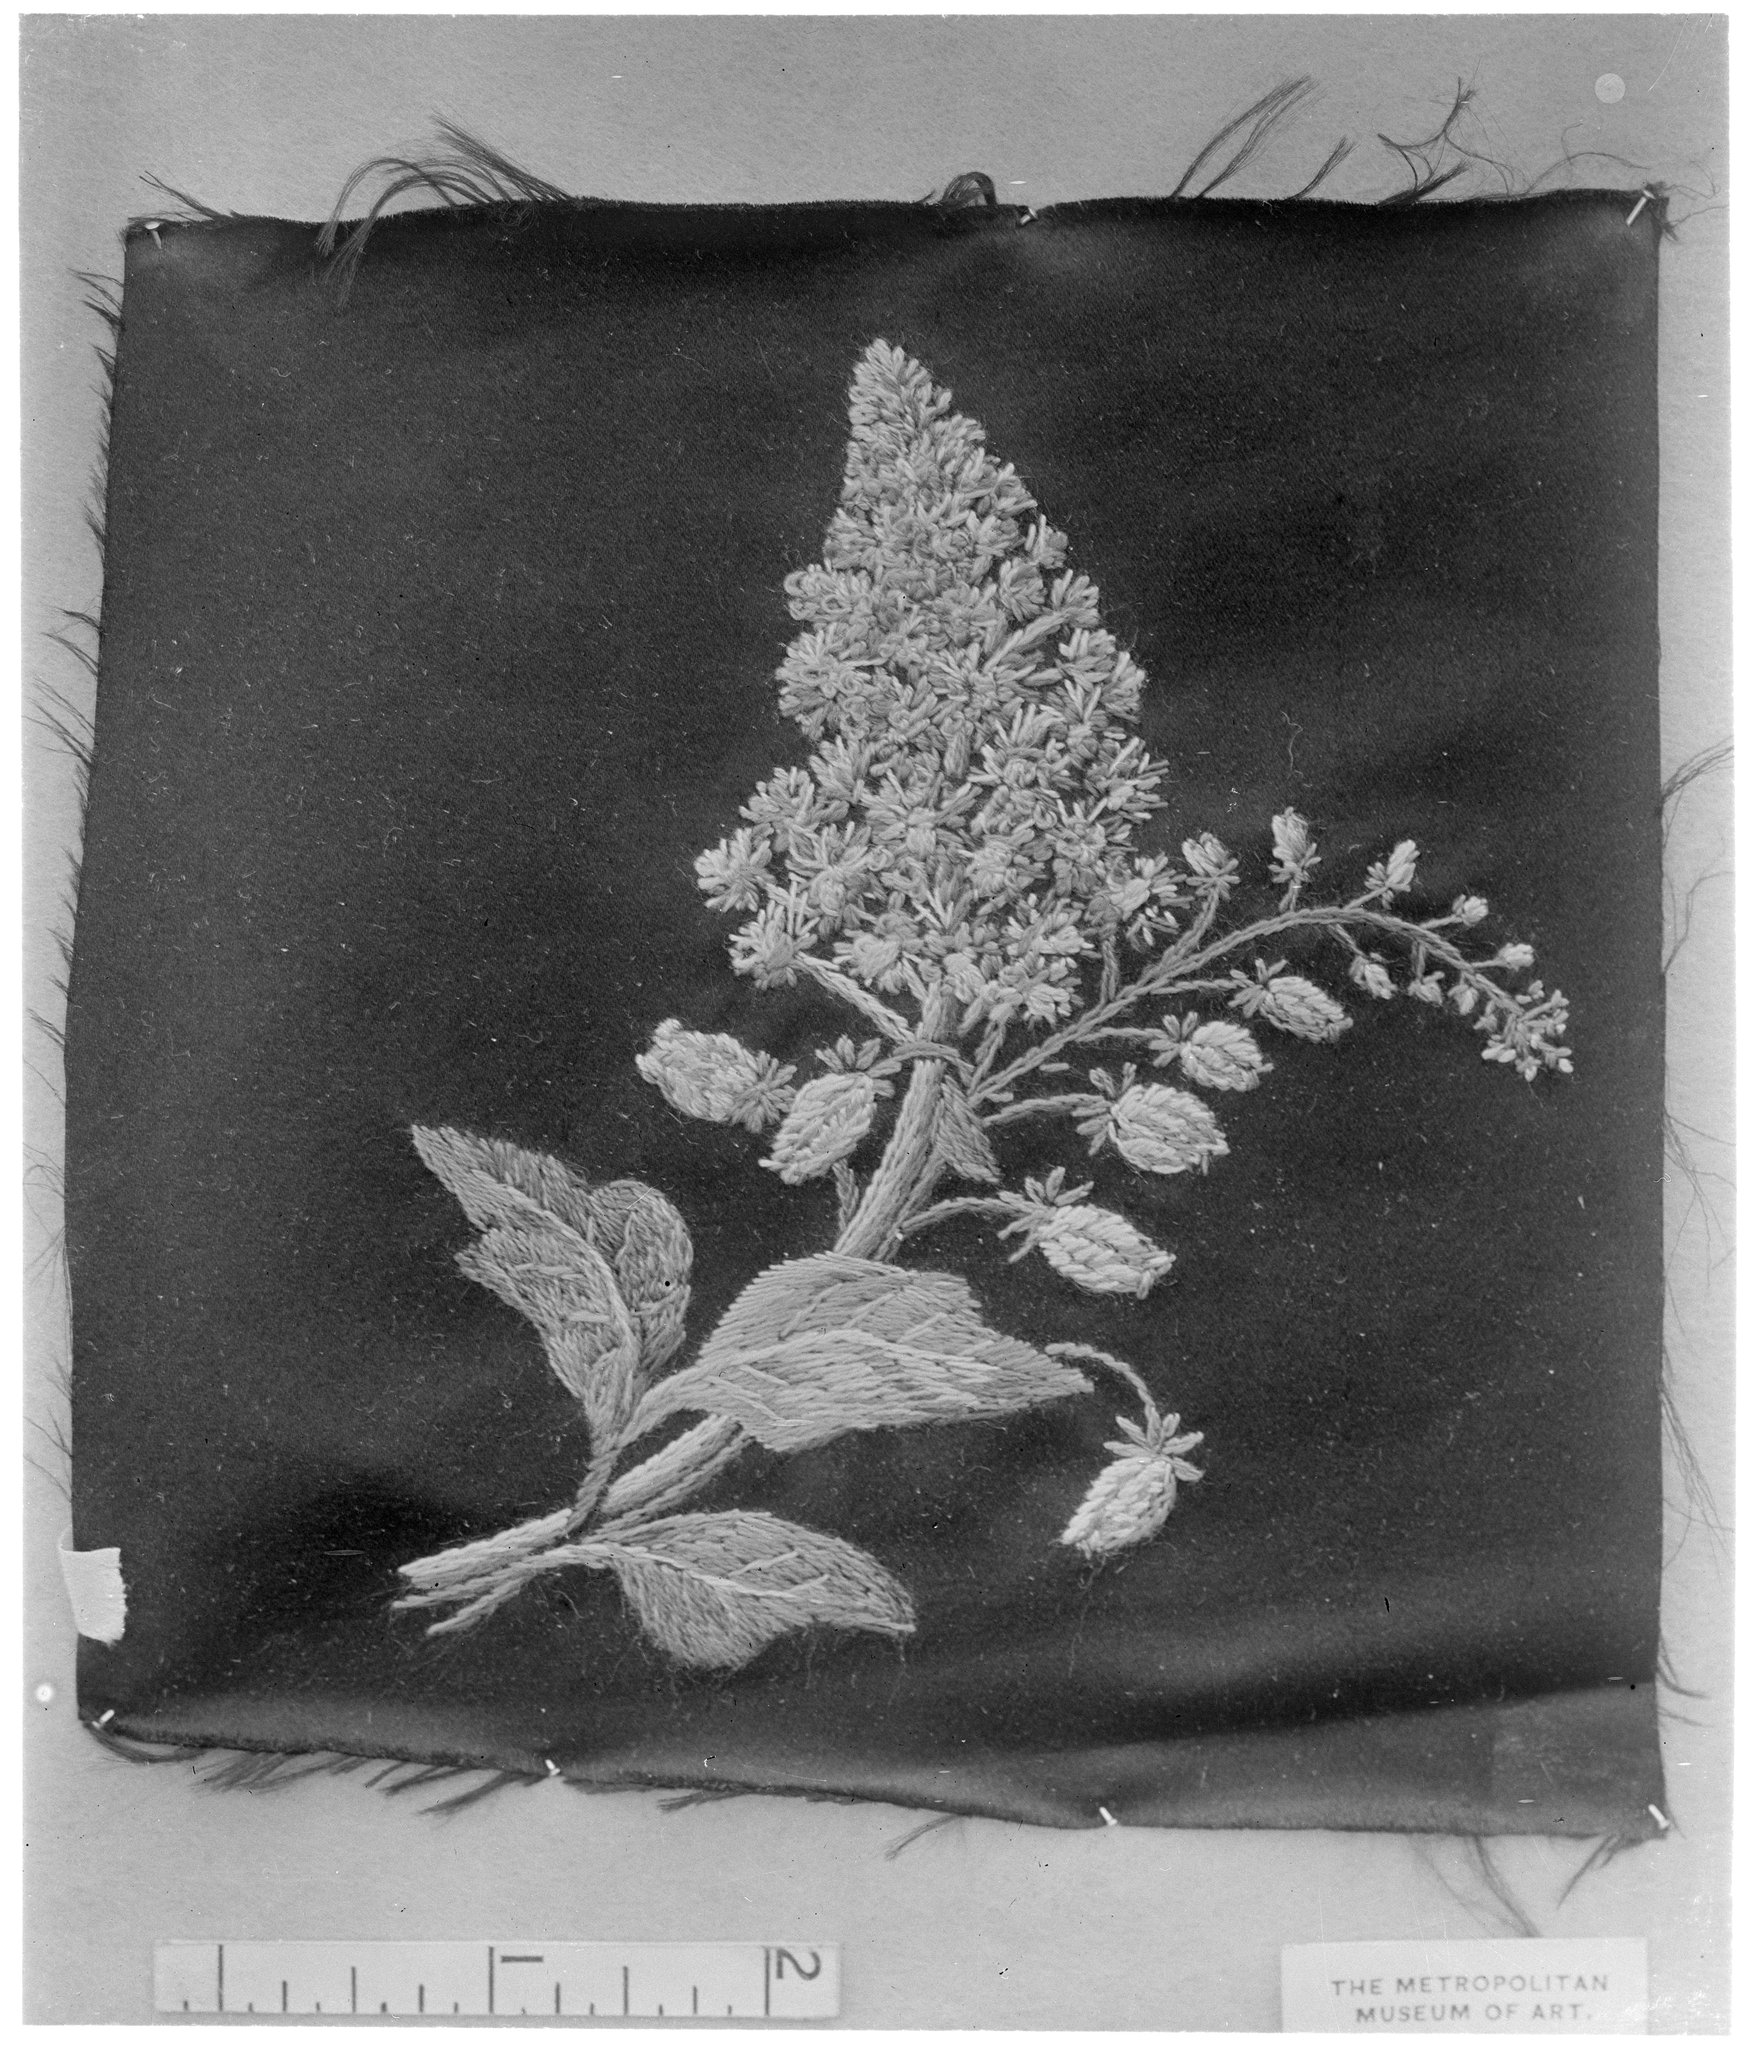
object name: square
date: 1801-1900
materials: silk